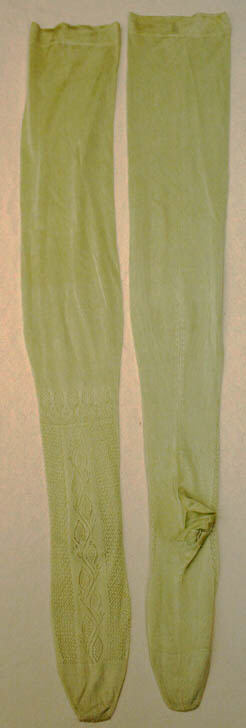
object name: stocking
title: Stockings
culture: french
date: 1801-1900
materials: silk